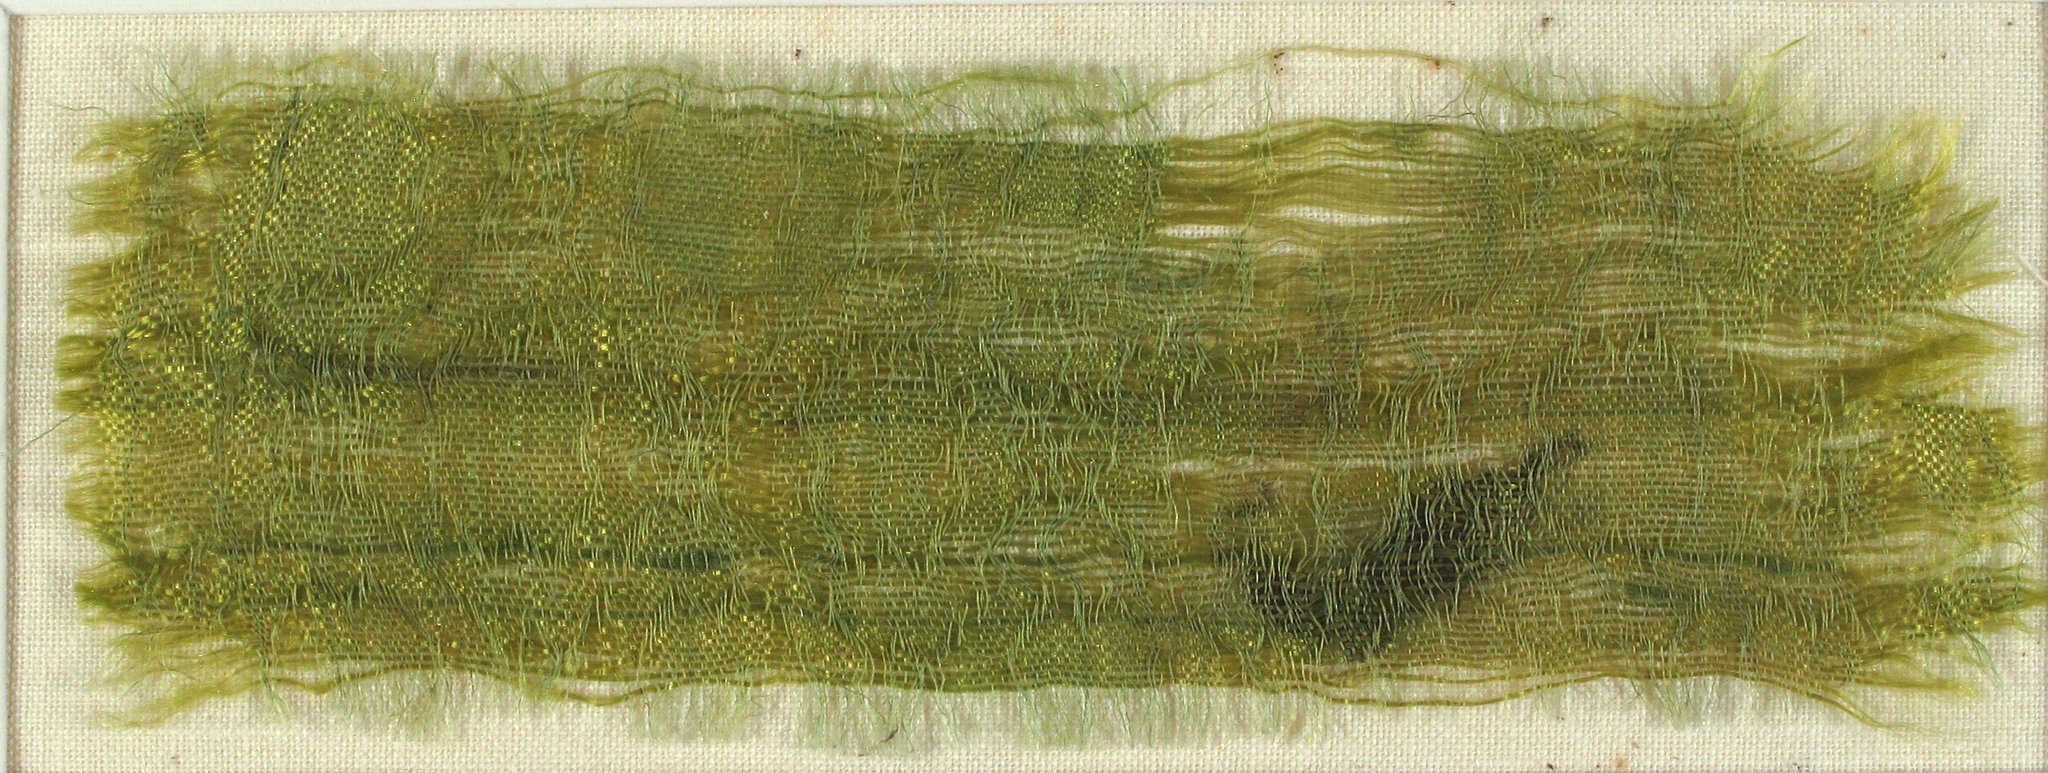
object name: textile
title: Textile with Trellis Pattern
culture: german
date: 1401-1500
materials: silk